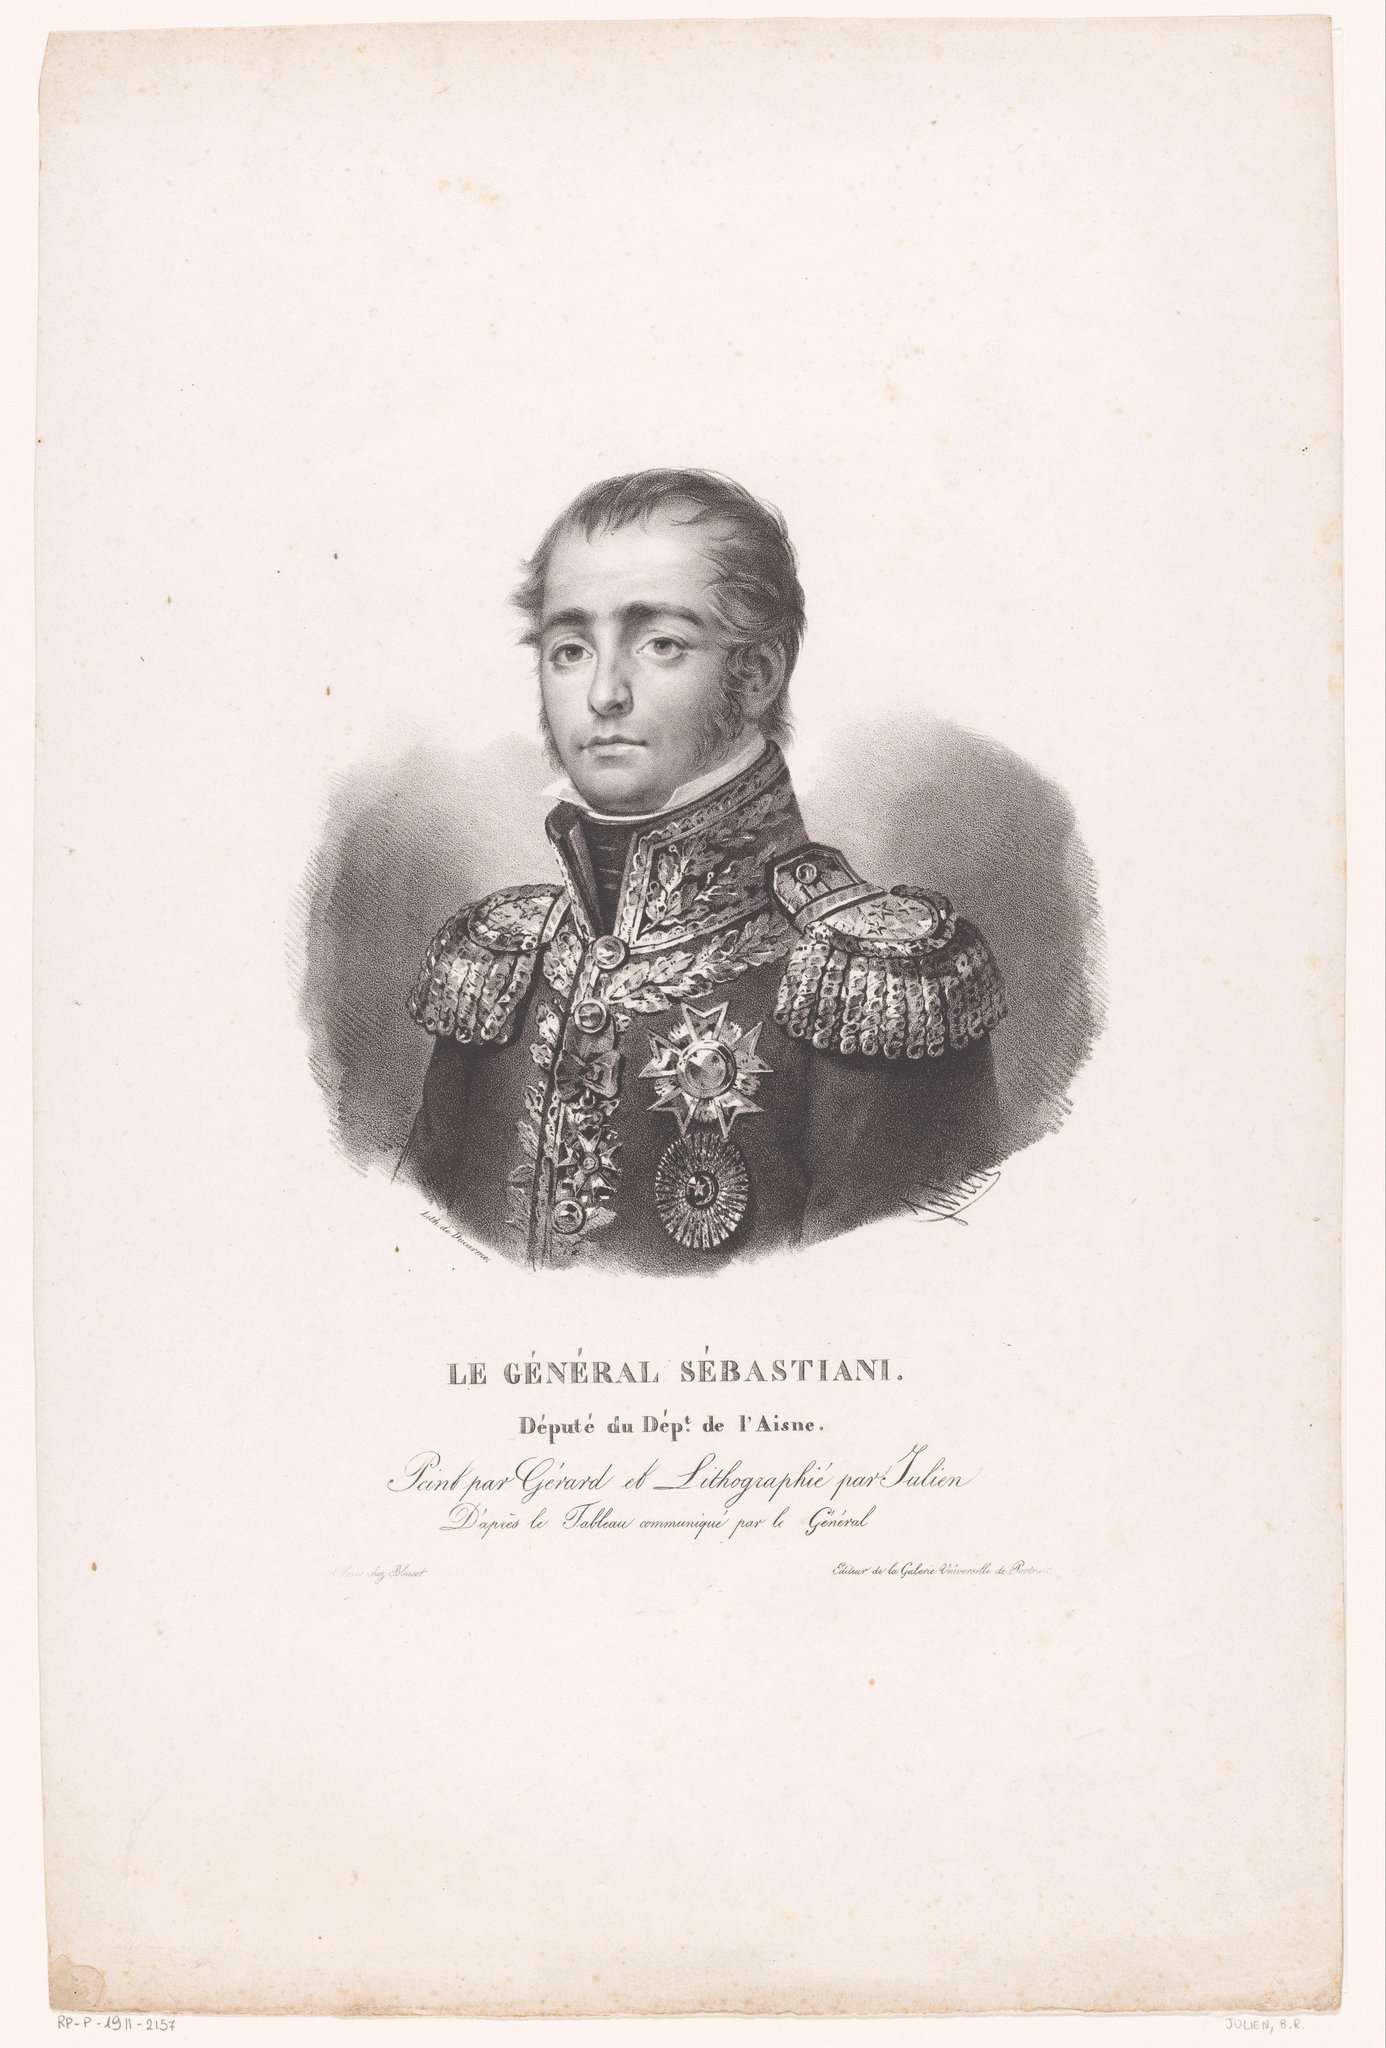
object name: print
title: Le général Sébastiani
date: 1835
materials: paper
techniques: lithograph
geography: paris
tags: paris, politician, historical persons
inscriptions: collector's mark: Lugt 2228a